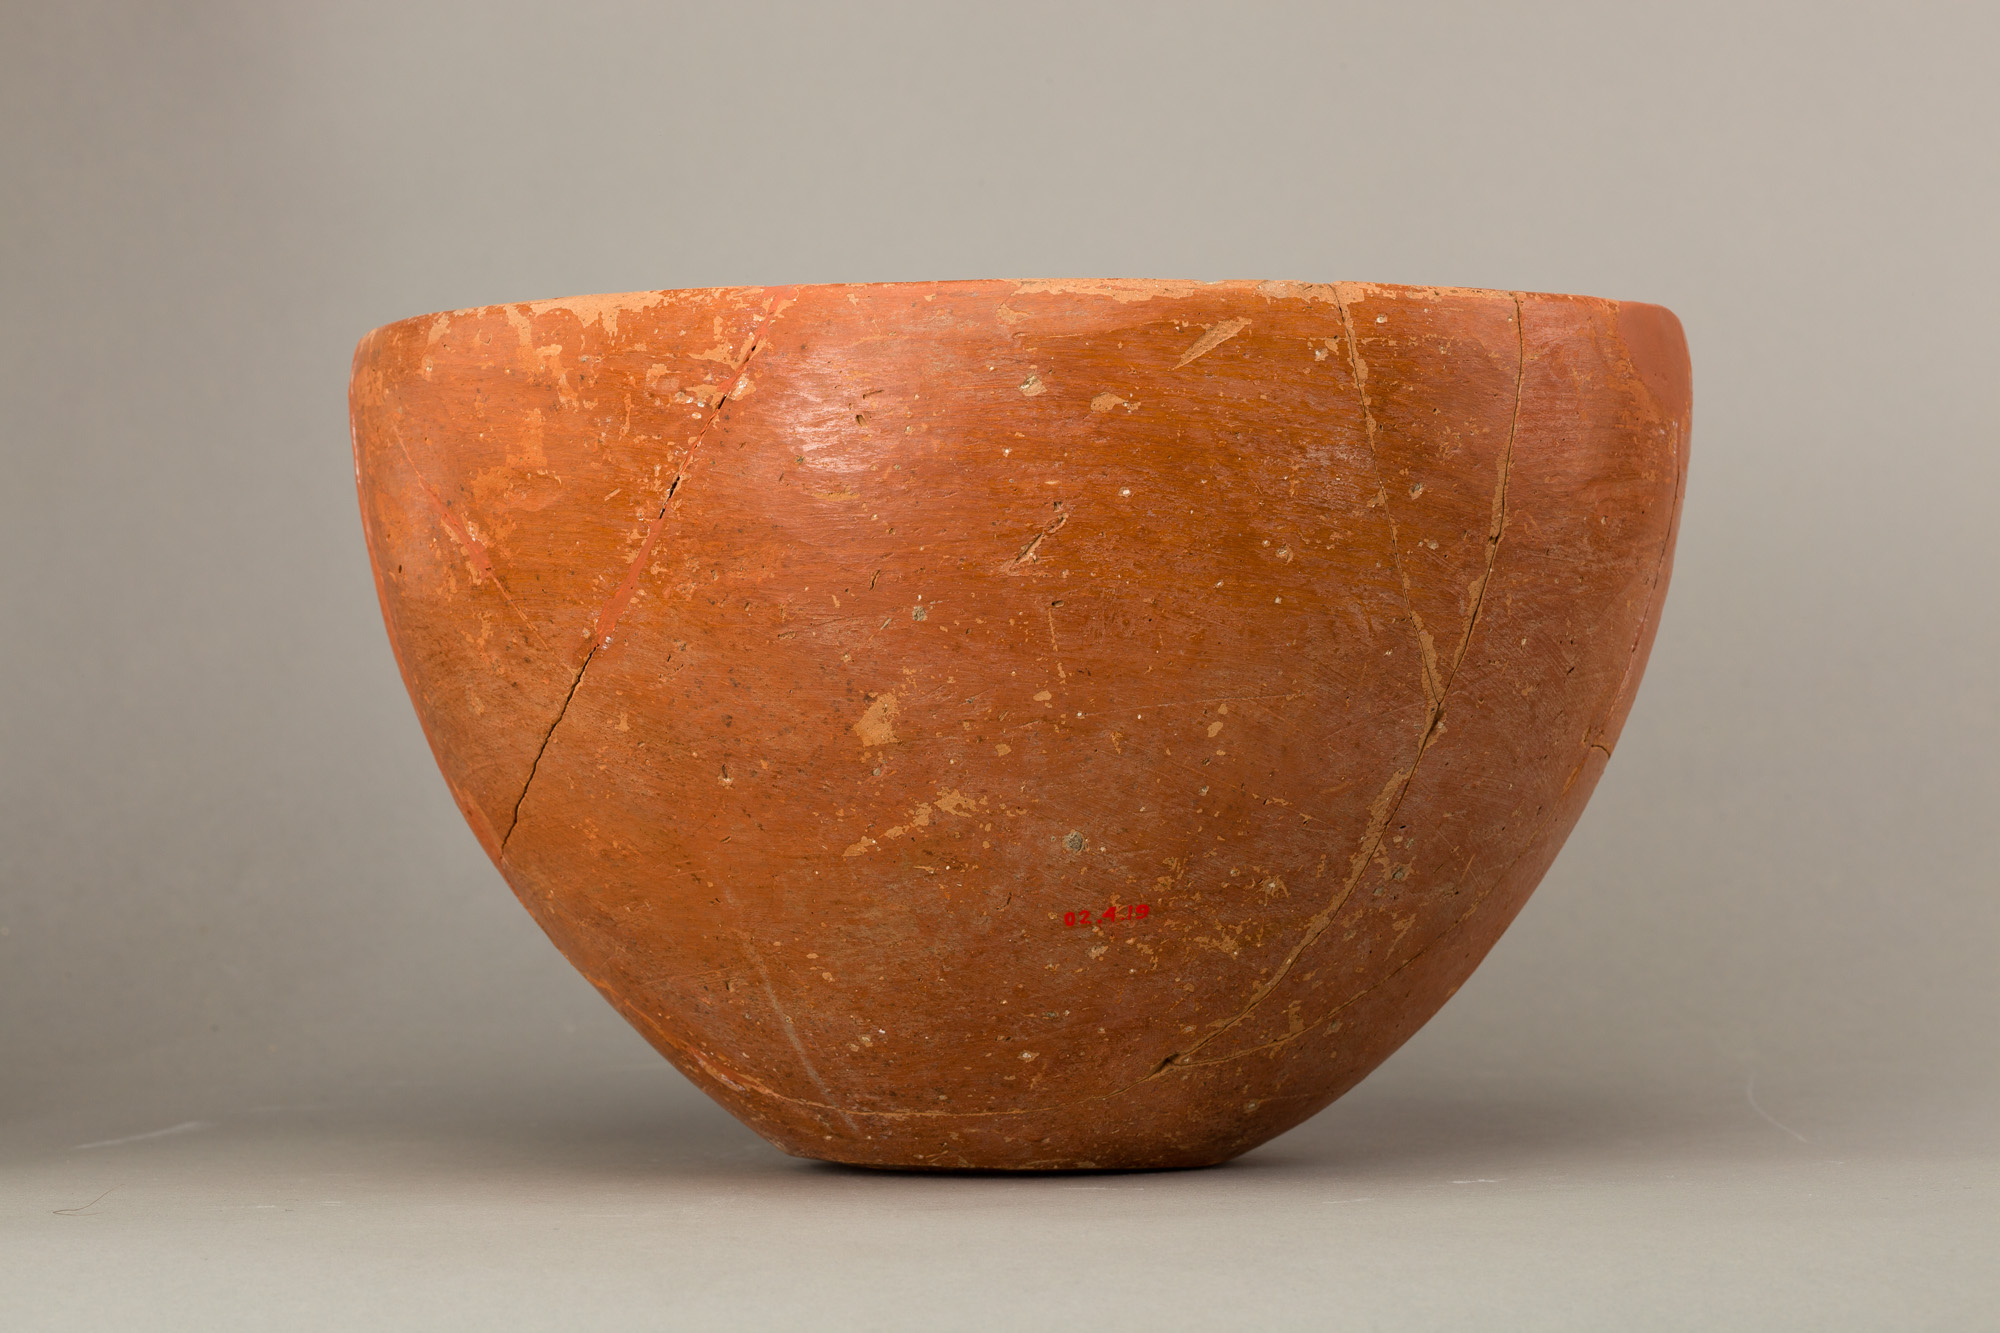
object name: bowl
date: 2960-2770 BCE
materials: pottery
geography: egypt